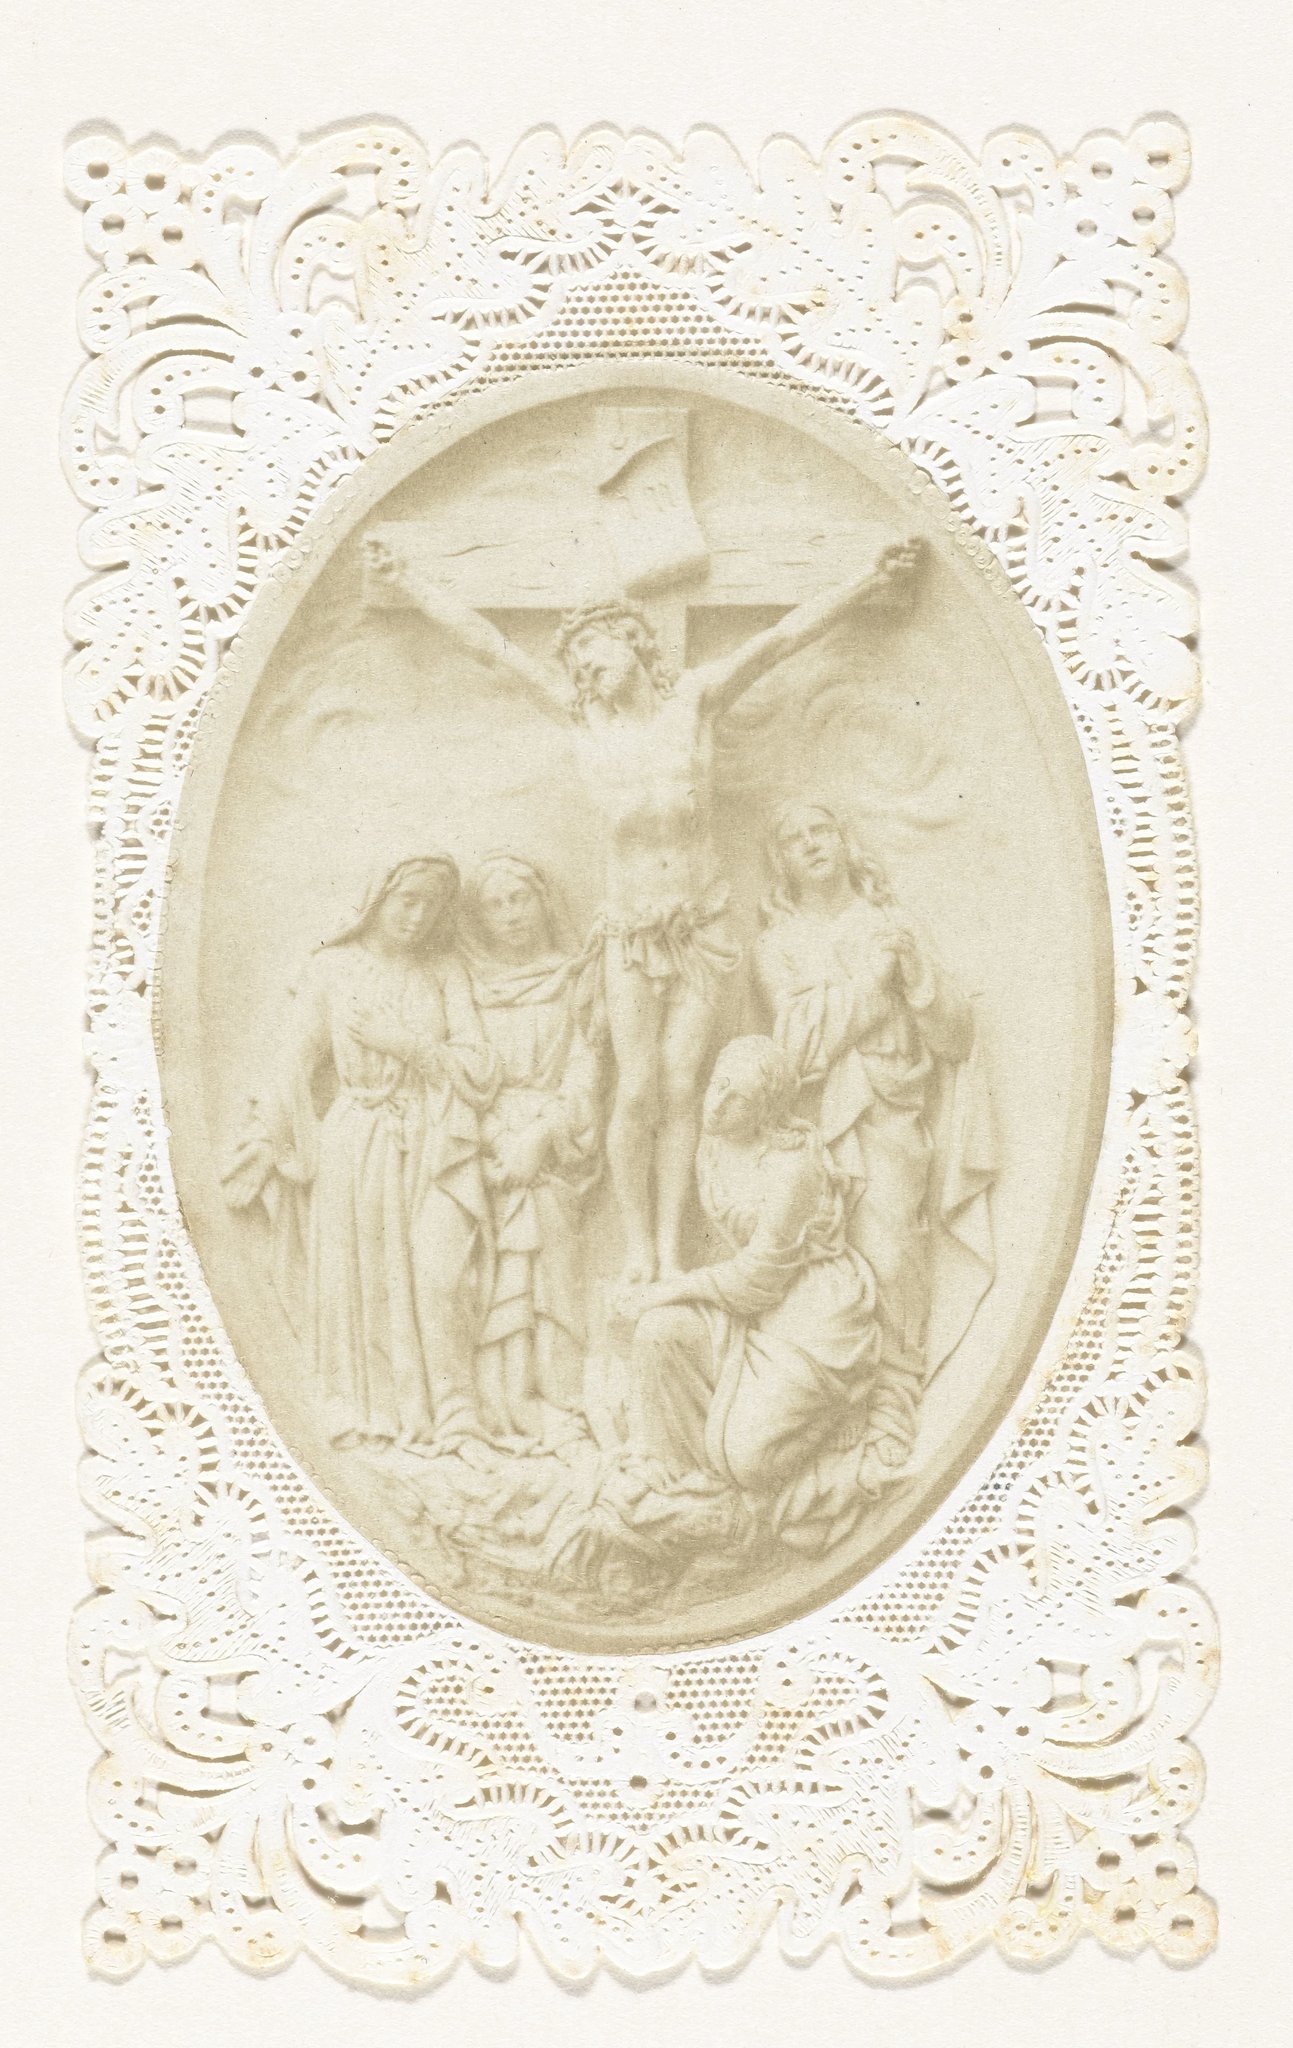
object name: prayer card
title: Reliëf van de kruisiging van Christus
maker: Anonymous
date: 1850-1860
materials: paper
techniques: albumen print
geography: paris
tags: the crucifixion of christ: christ's death on the cross; golgotha (matthew 27:45-58; mark 15:33-45; luke 23:44-52; john 19:25-38)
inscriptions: address: ‘Paris, maison Basset,/ 33, r. de Seine.’, inscription: ‘Je vous adore, divin (...)’